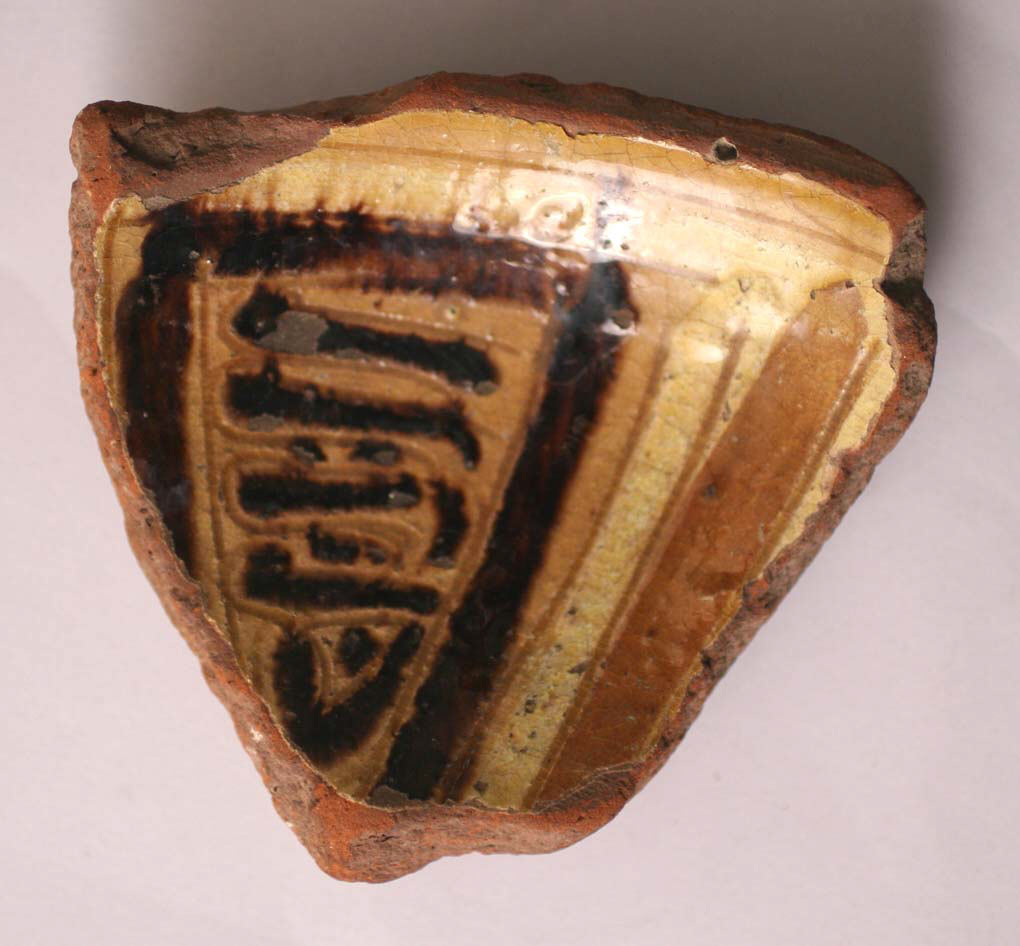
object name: ceramic fragment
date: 1301-1500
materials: earthenware, glaze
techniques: coloring, incising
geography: egypt